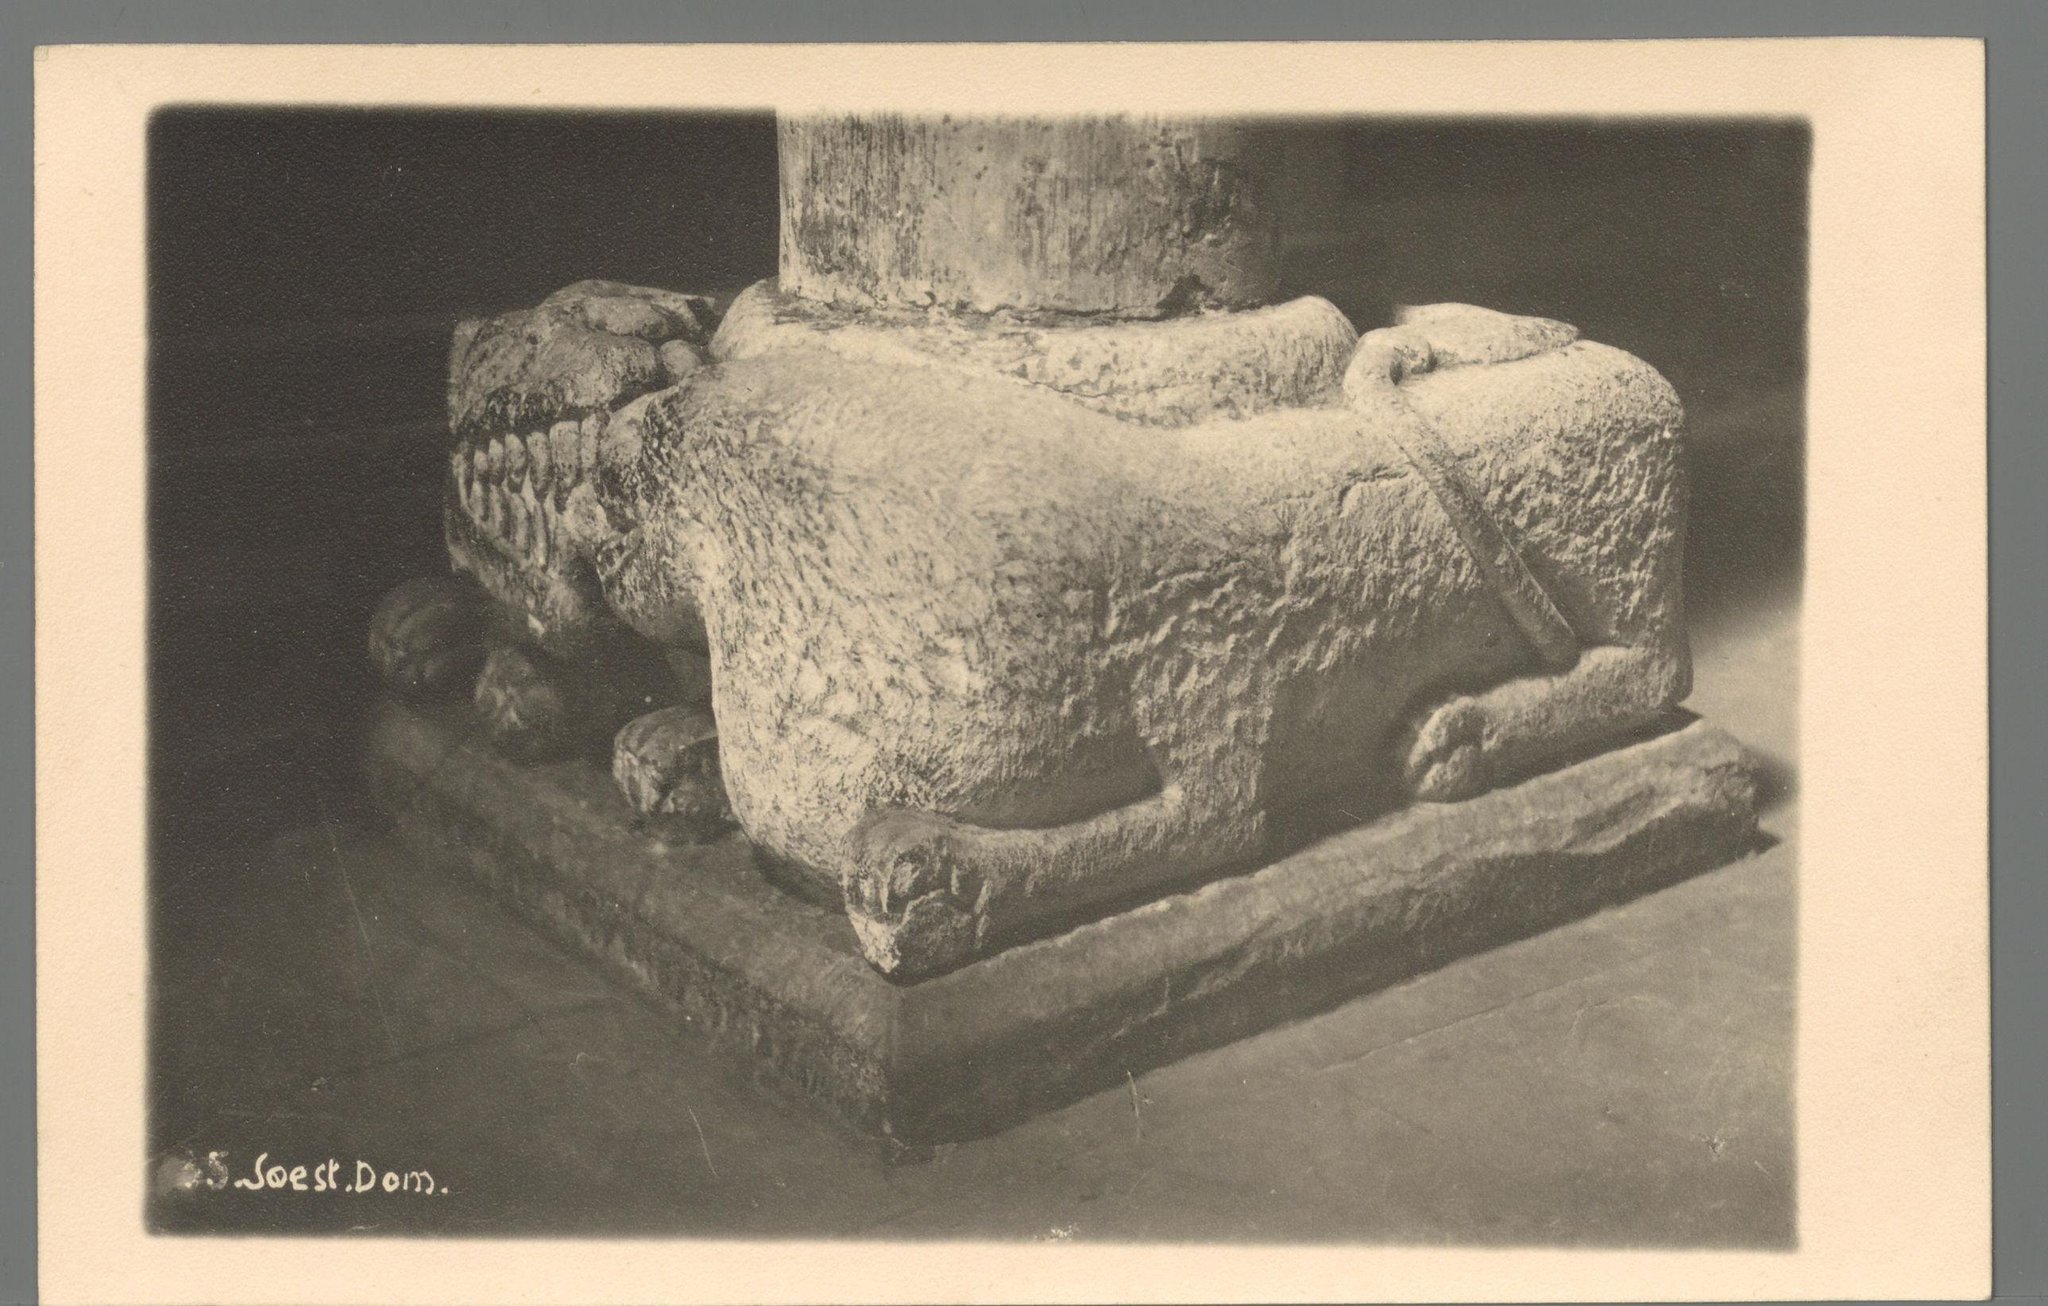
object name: photograph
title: Soest. Dom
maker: w. lange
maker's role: fotograaf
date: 1905-1930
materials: photographic support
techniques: gelatin silver print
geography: soest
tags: column, pillar ~ architecture, interior of church